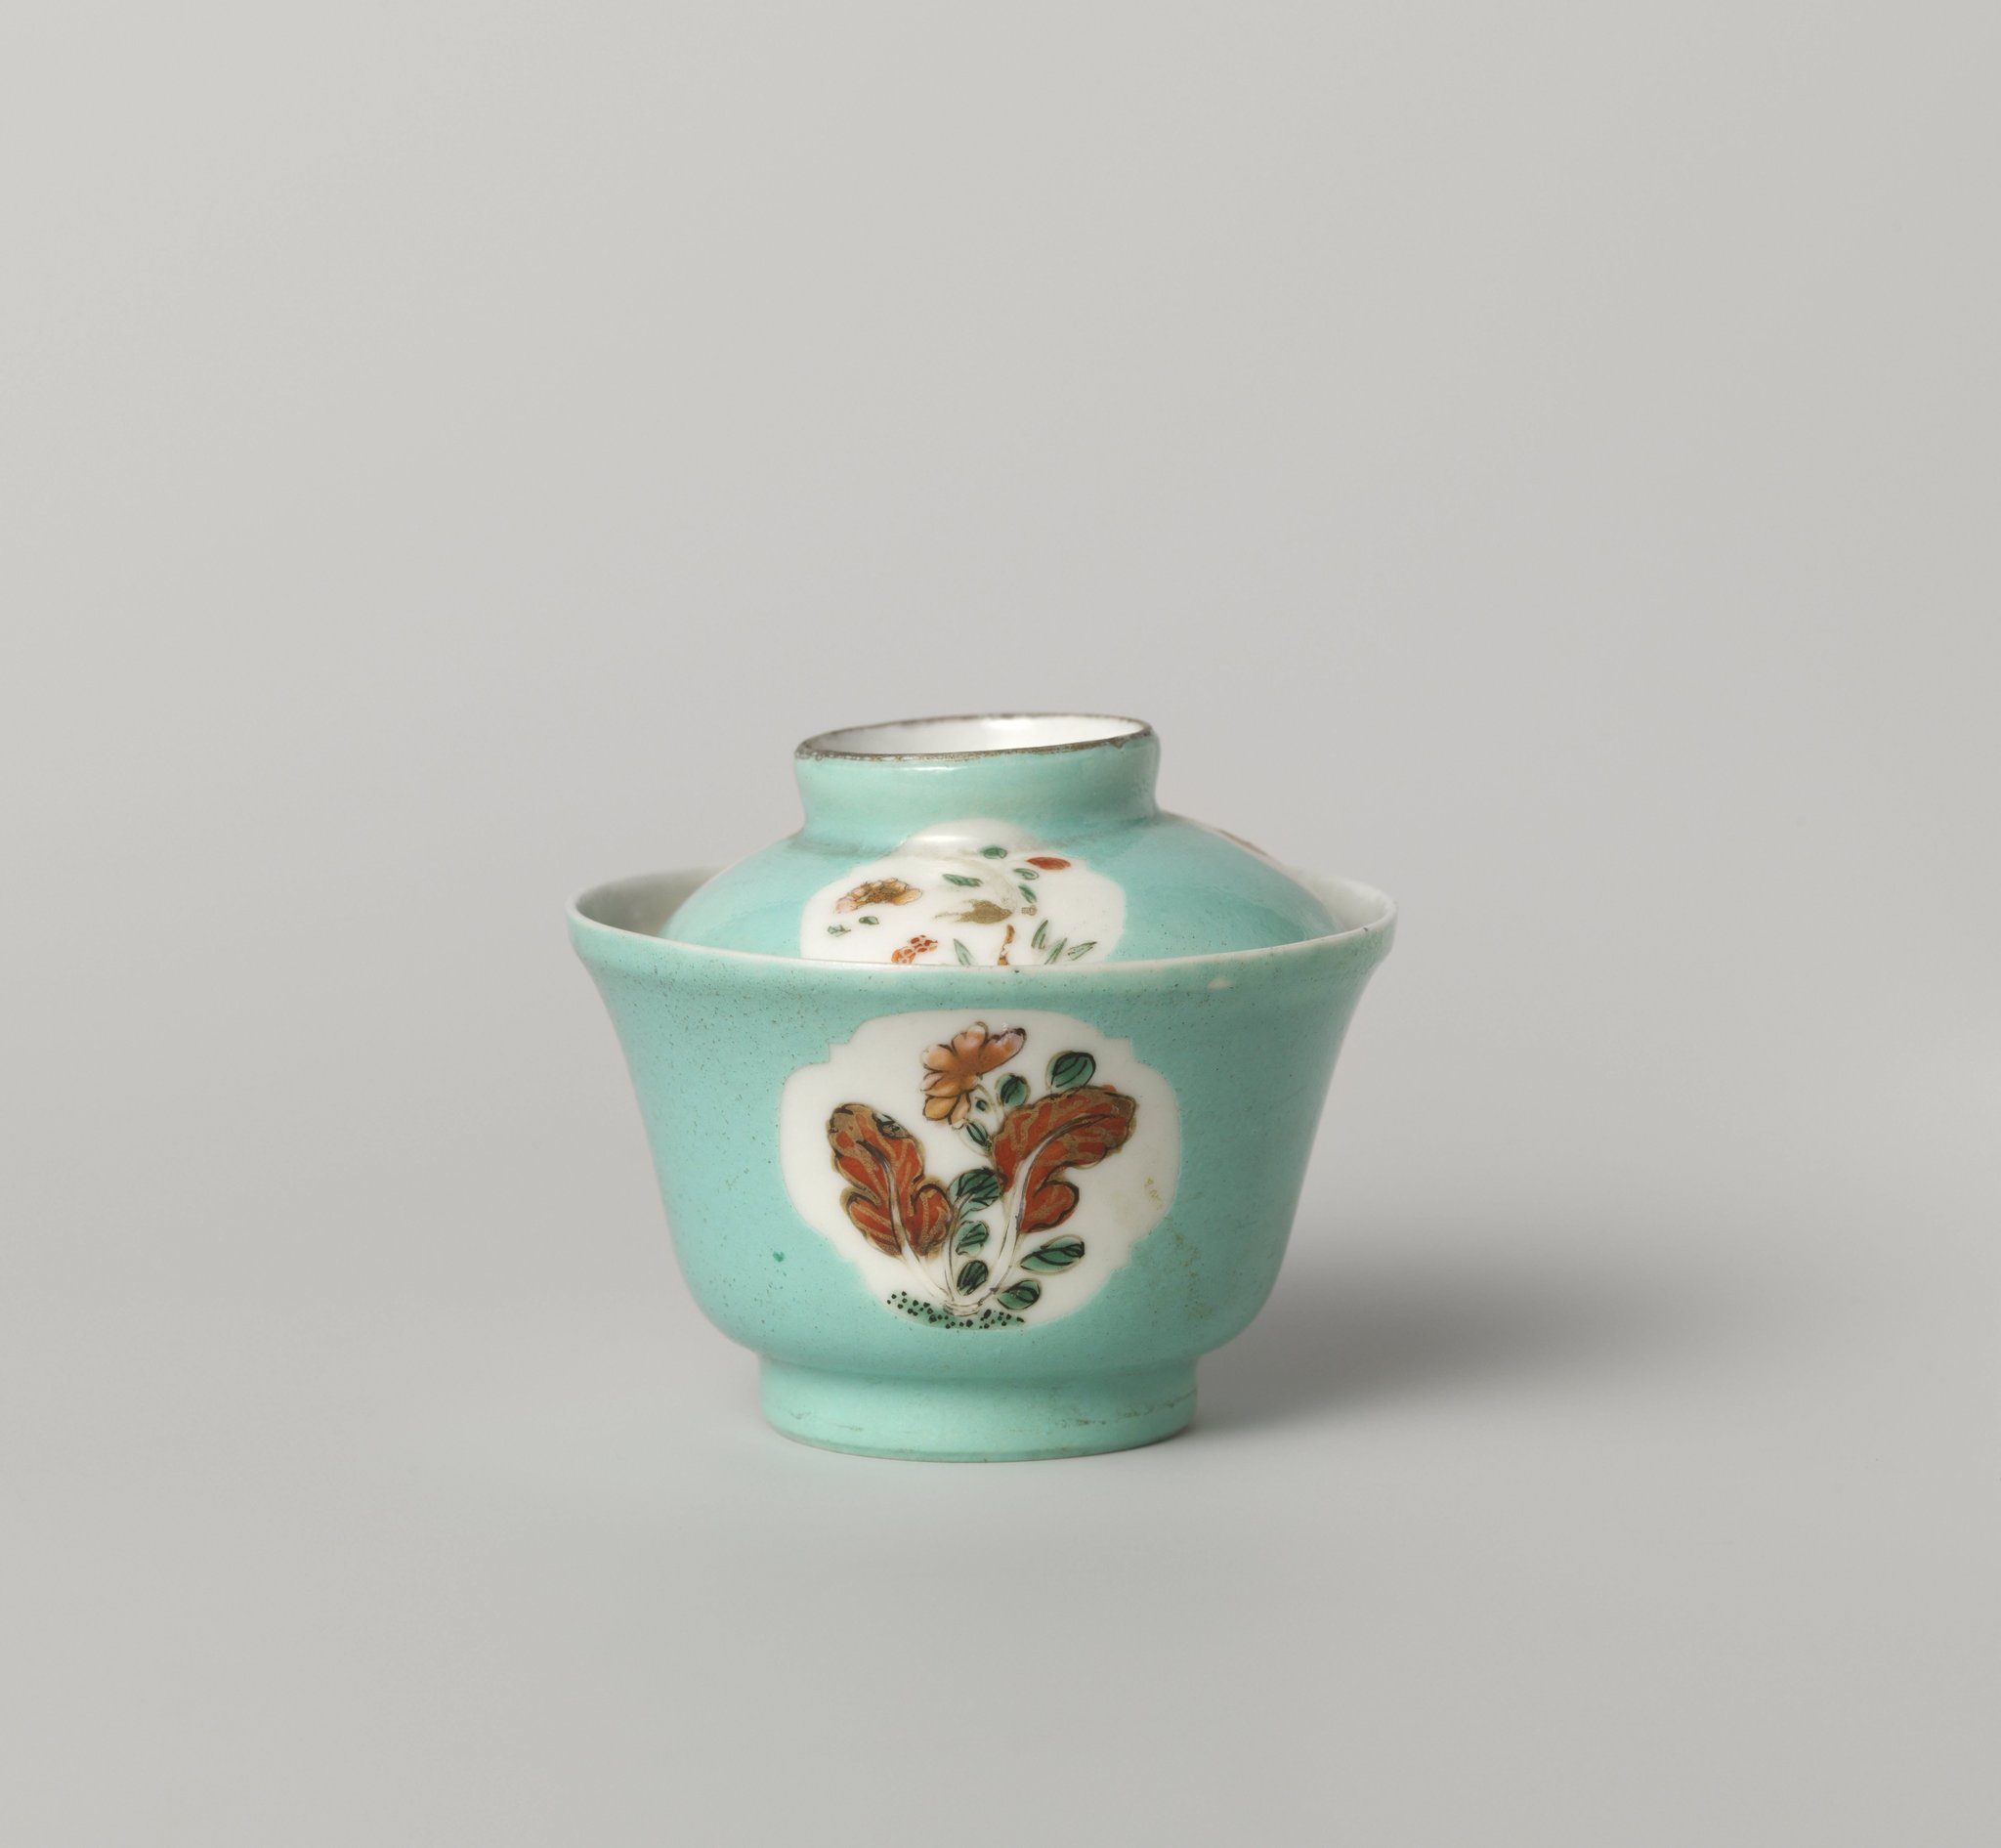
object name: kop en schotel, kop en schotel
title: Bell-shaped covered cup with flowering plants in shaped panels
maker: Anonymous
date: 1760-1780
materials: glaze, gold, paint, porcelain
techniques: firing, gilding, turning, vitrification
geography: china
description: Deksel van klokvormige dekselkop van porselein, bedekt met een turquoise glazuur en berschilderd in blauw, rood, roze, groen, zwart en goud. Bedekt met een turquoise glazuur met hierin uitgespaard in het centrum een geschulpt medaillon met plant, daaromheen drie uitgespaarde cartouches met bloeiende planten en een vogel op een tak. Twee barsten in de rand. Famille rose.